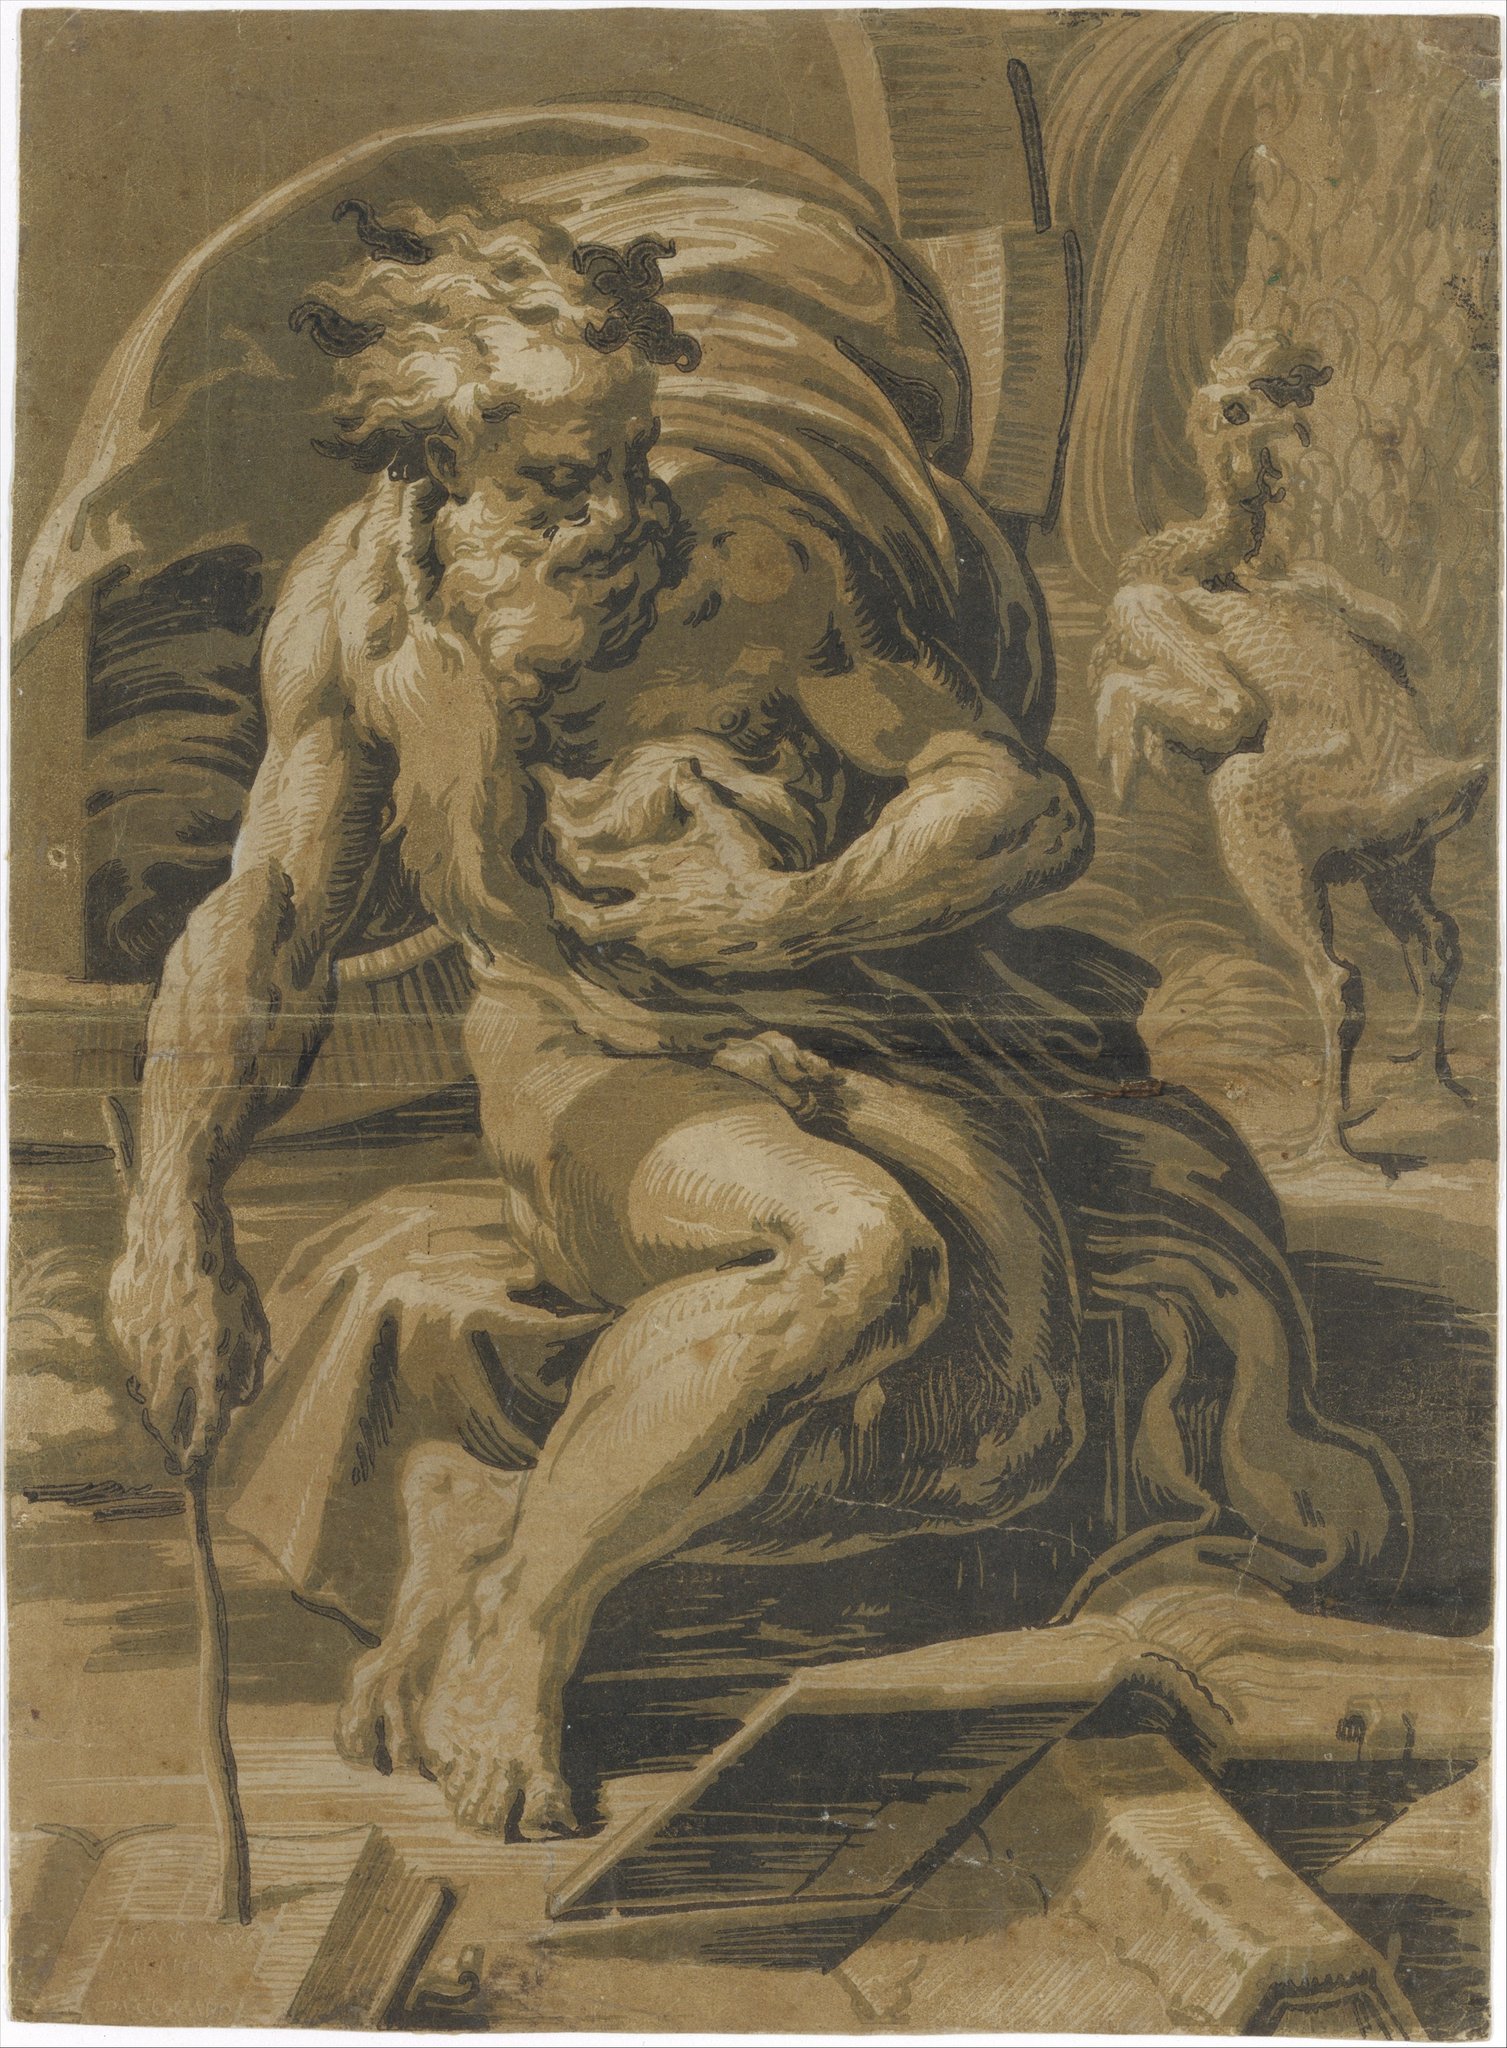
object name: print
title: Diogenes, seated before his barrel, reading from a book, a plucked hen standing behind him at right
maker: ugo da carpi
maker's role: artist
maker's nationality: italian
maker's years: 1480-1532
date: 1527-1530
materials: ink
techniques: woodcut, printing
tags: chickens,diogenes,reading